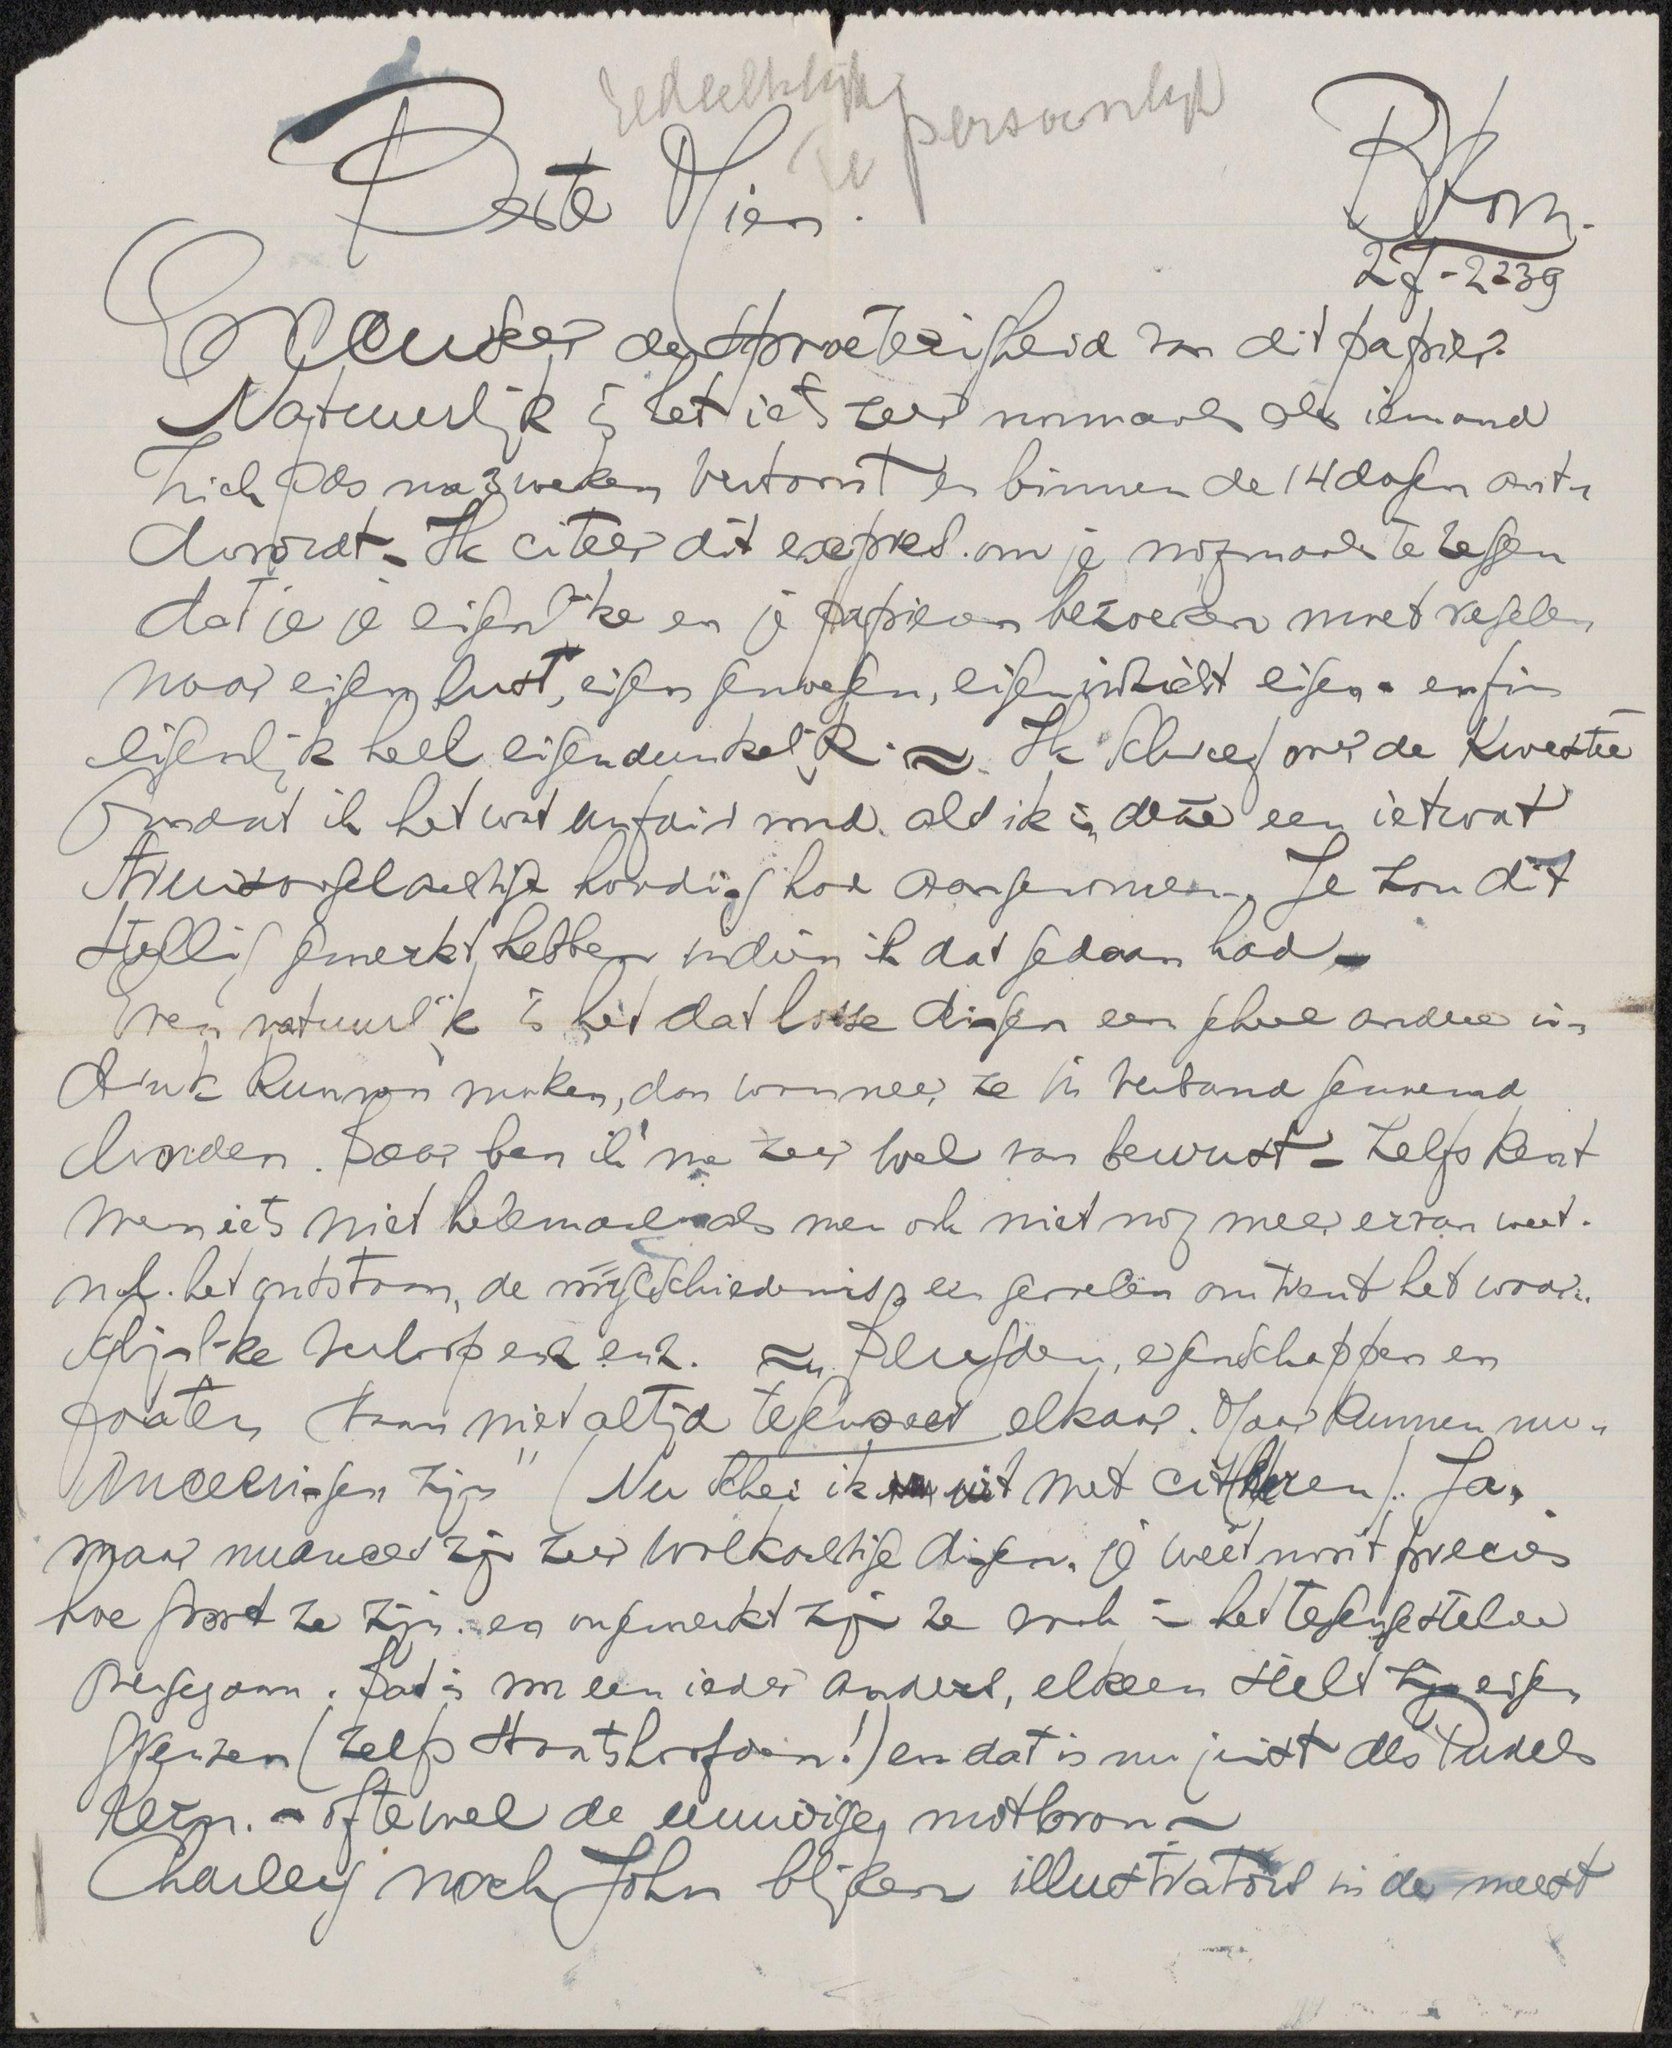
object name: letter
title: Brief aan Mien Cambier van Nooten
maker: dick ket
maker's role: draughtsman, print maker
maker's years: 1902-1940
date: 1939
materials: ink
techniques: pen, writing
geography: bennekom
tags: arnhem, mien cambier van nooten, amsterdam, print maker, draughtsman, john rädecker, charley toorop, haarlem, dollmaker, textile artist, nelly johanna hagelen-schilt, painter, eppo doeve, music, illustration ~ printed matter, book, painting (including book-illumination, miniature-painting)